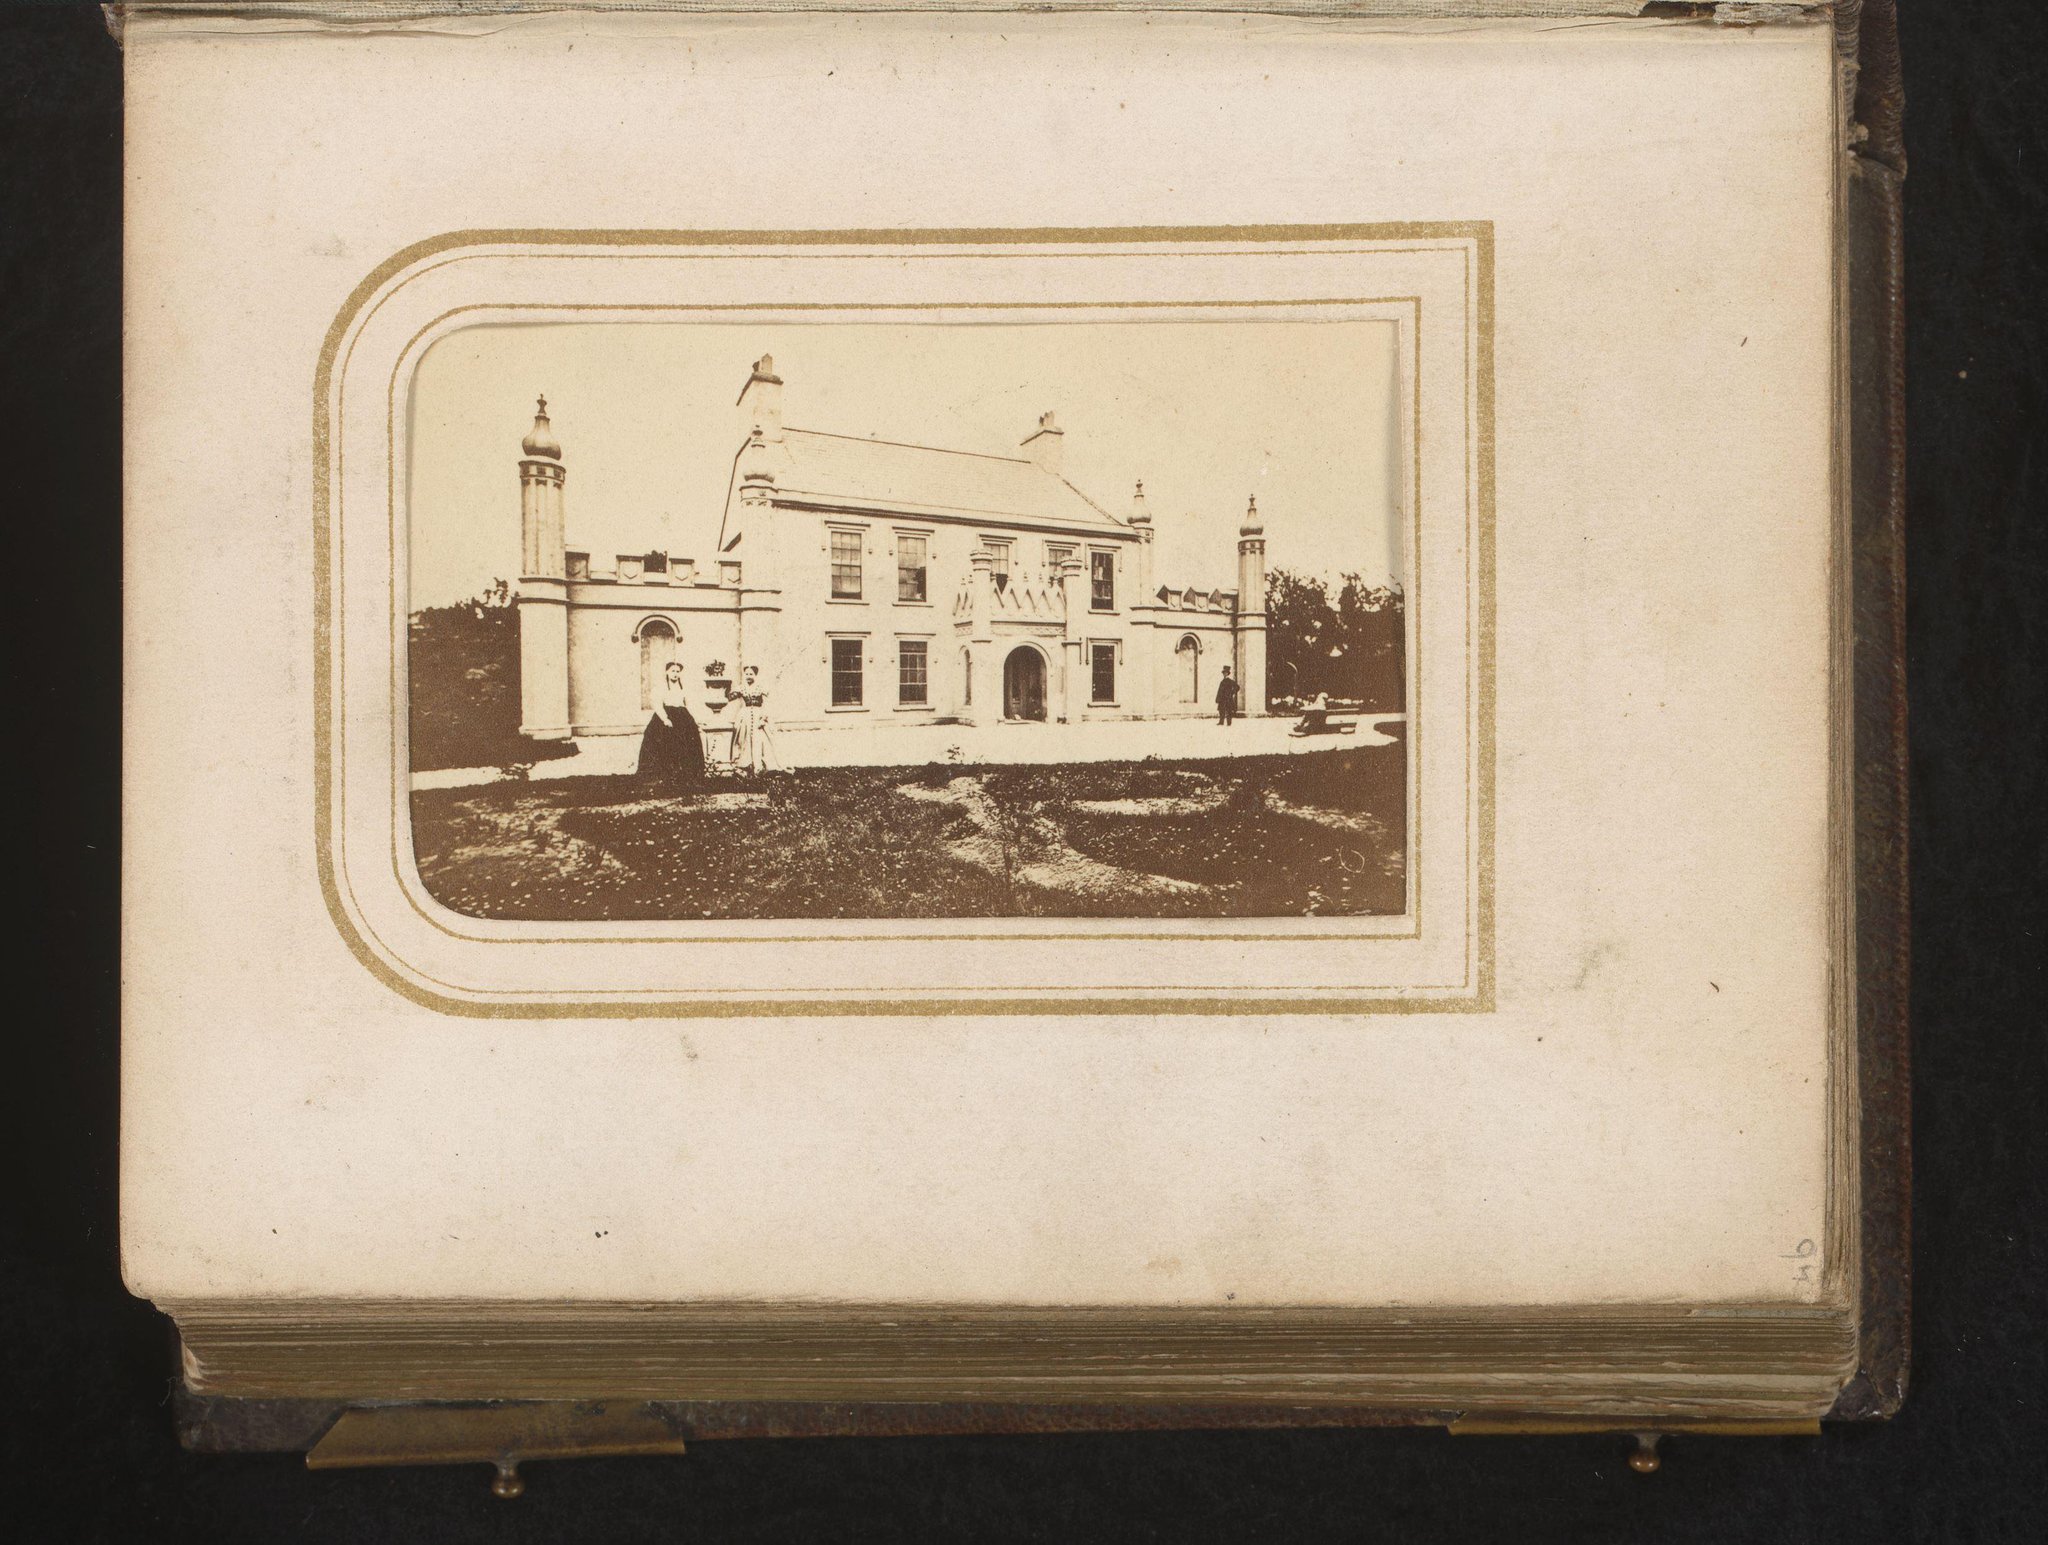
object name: photograph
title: Gezicht op een landhuis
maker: james a. cumine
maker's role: fotograaf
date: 1860-1880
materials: cardboard, paper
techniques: albumen print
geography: belfast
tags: villa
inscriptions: inscription: ‘J. A. Cumine/ 29, High Street./ BELFAST.’